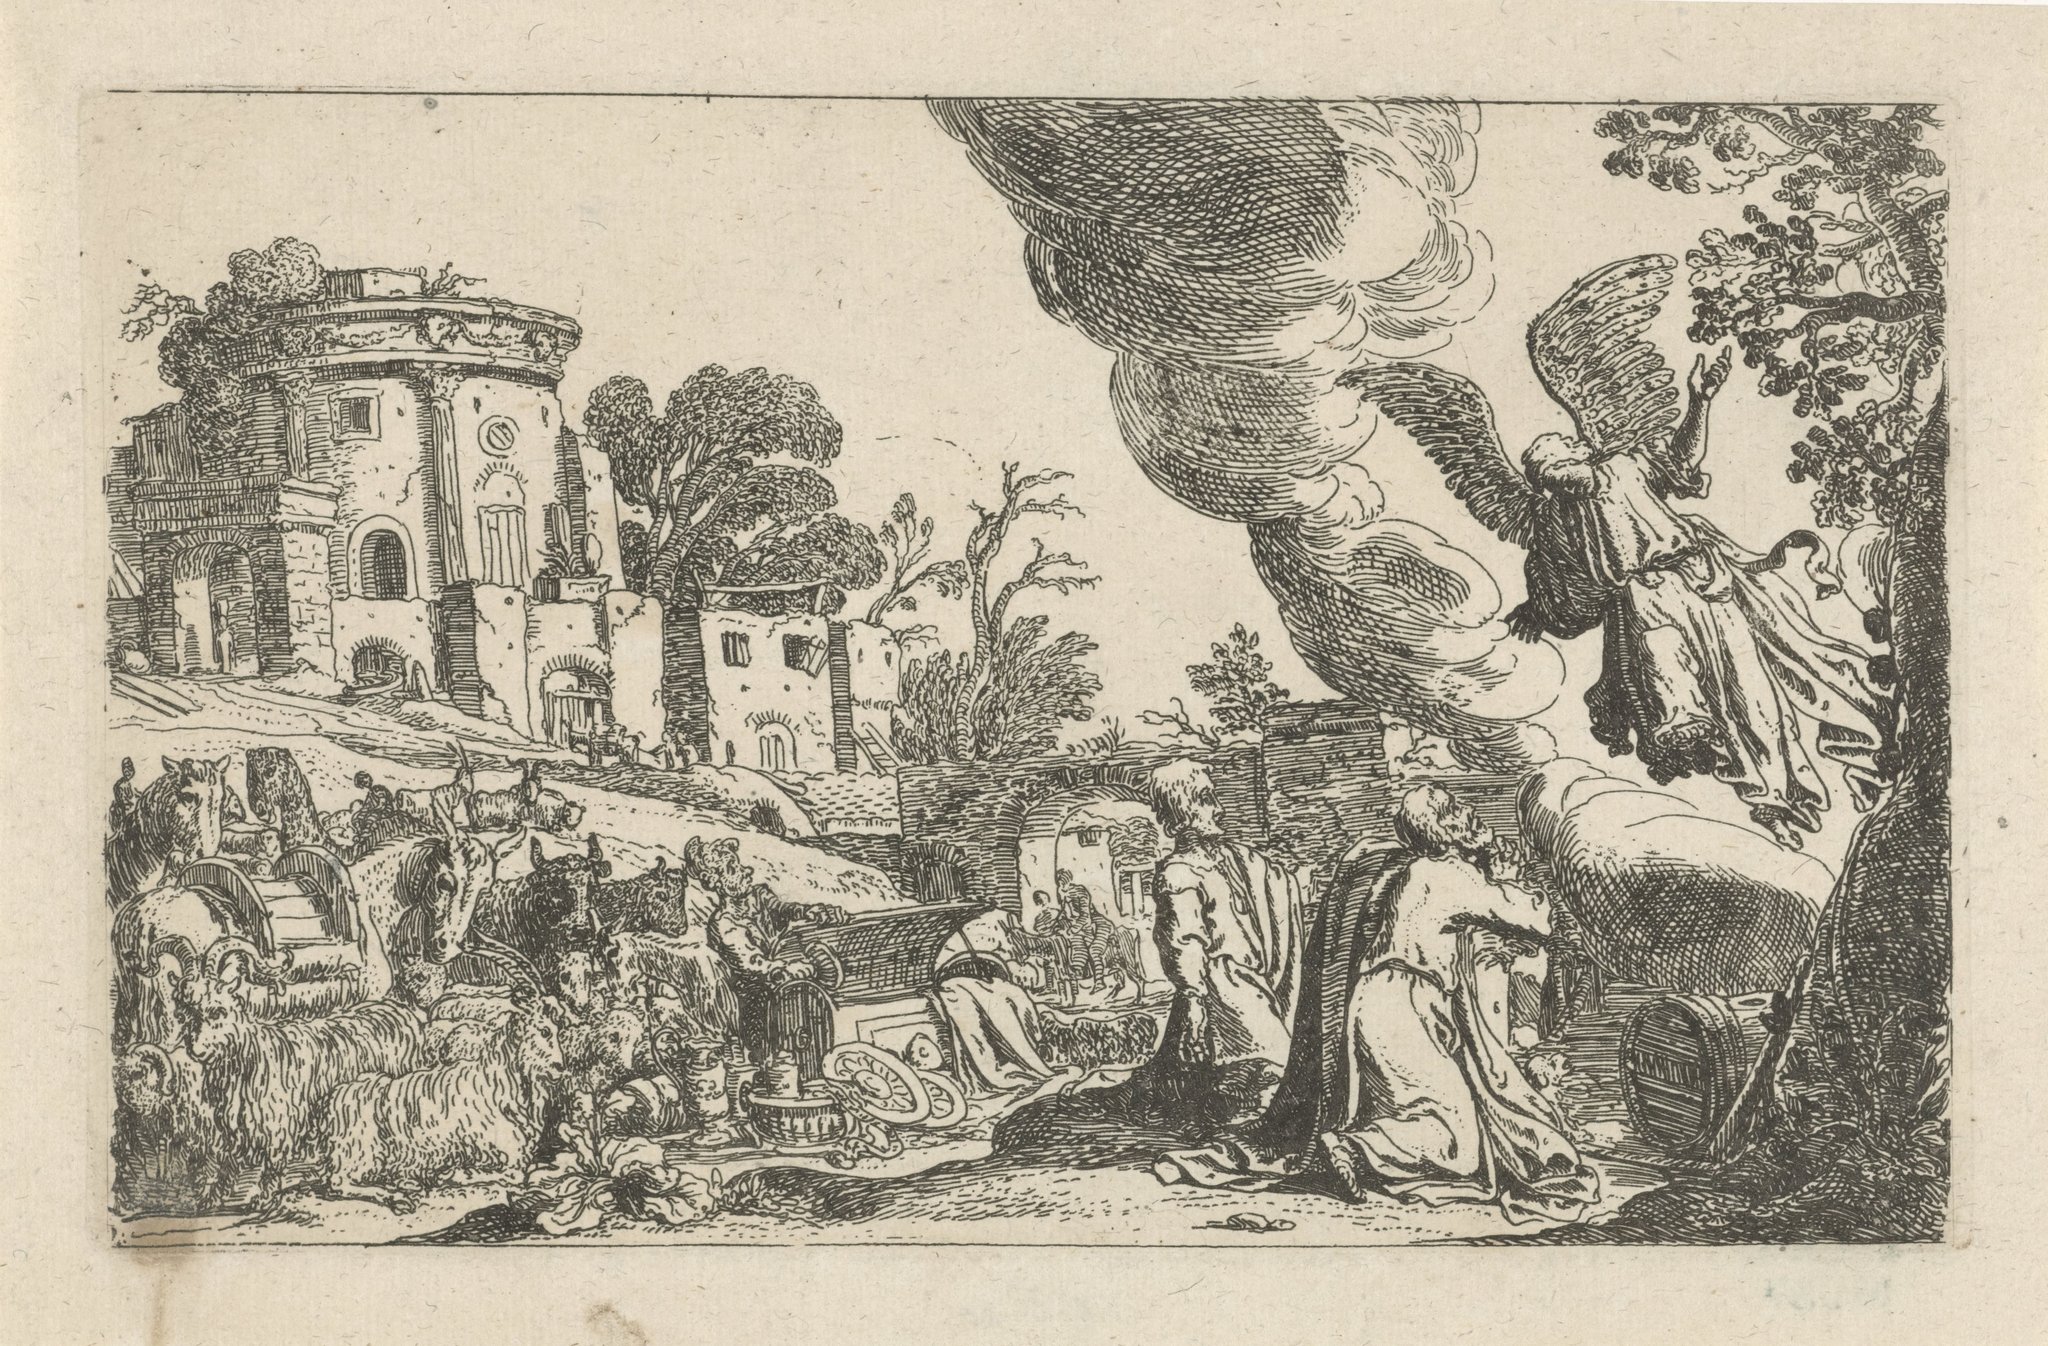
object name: print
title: De engel neemt afscheid van Tobias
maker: claes moeyaert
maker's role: draughtsman, painter, print maker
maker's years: 1592-1655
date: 1612-1655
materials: paper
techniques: etching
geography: amsterdam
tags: the angel raphael disappears into the sky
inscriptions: collector's mark: Lugt 2165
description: Tobit en Tobias kijken geknield op naar de engel Rafaël die zich aan hen kenbaar maakt en verdwijnt in de lucht. Op de achtergrond de helft van Tobias' bezittingen, die hij de engel wilde aanbieden.